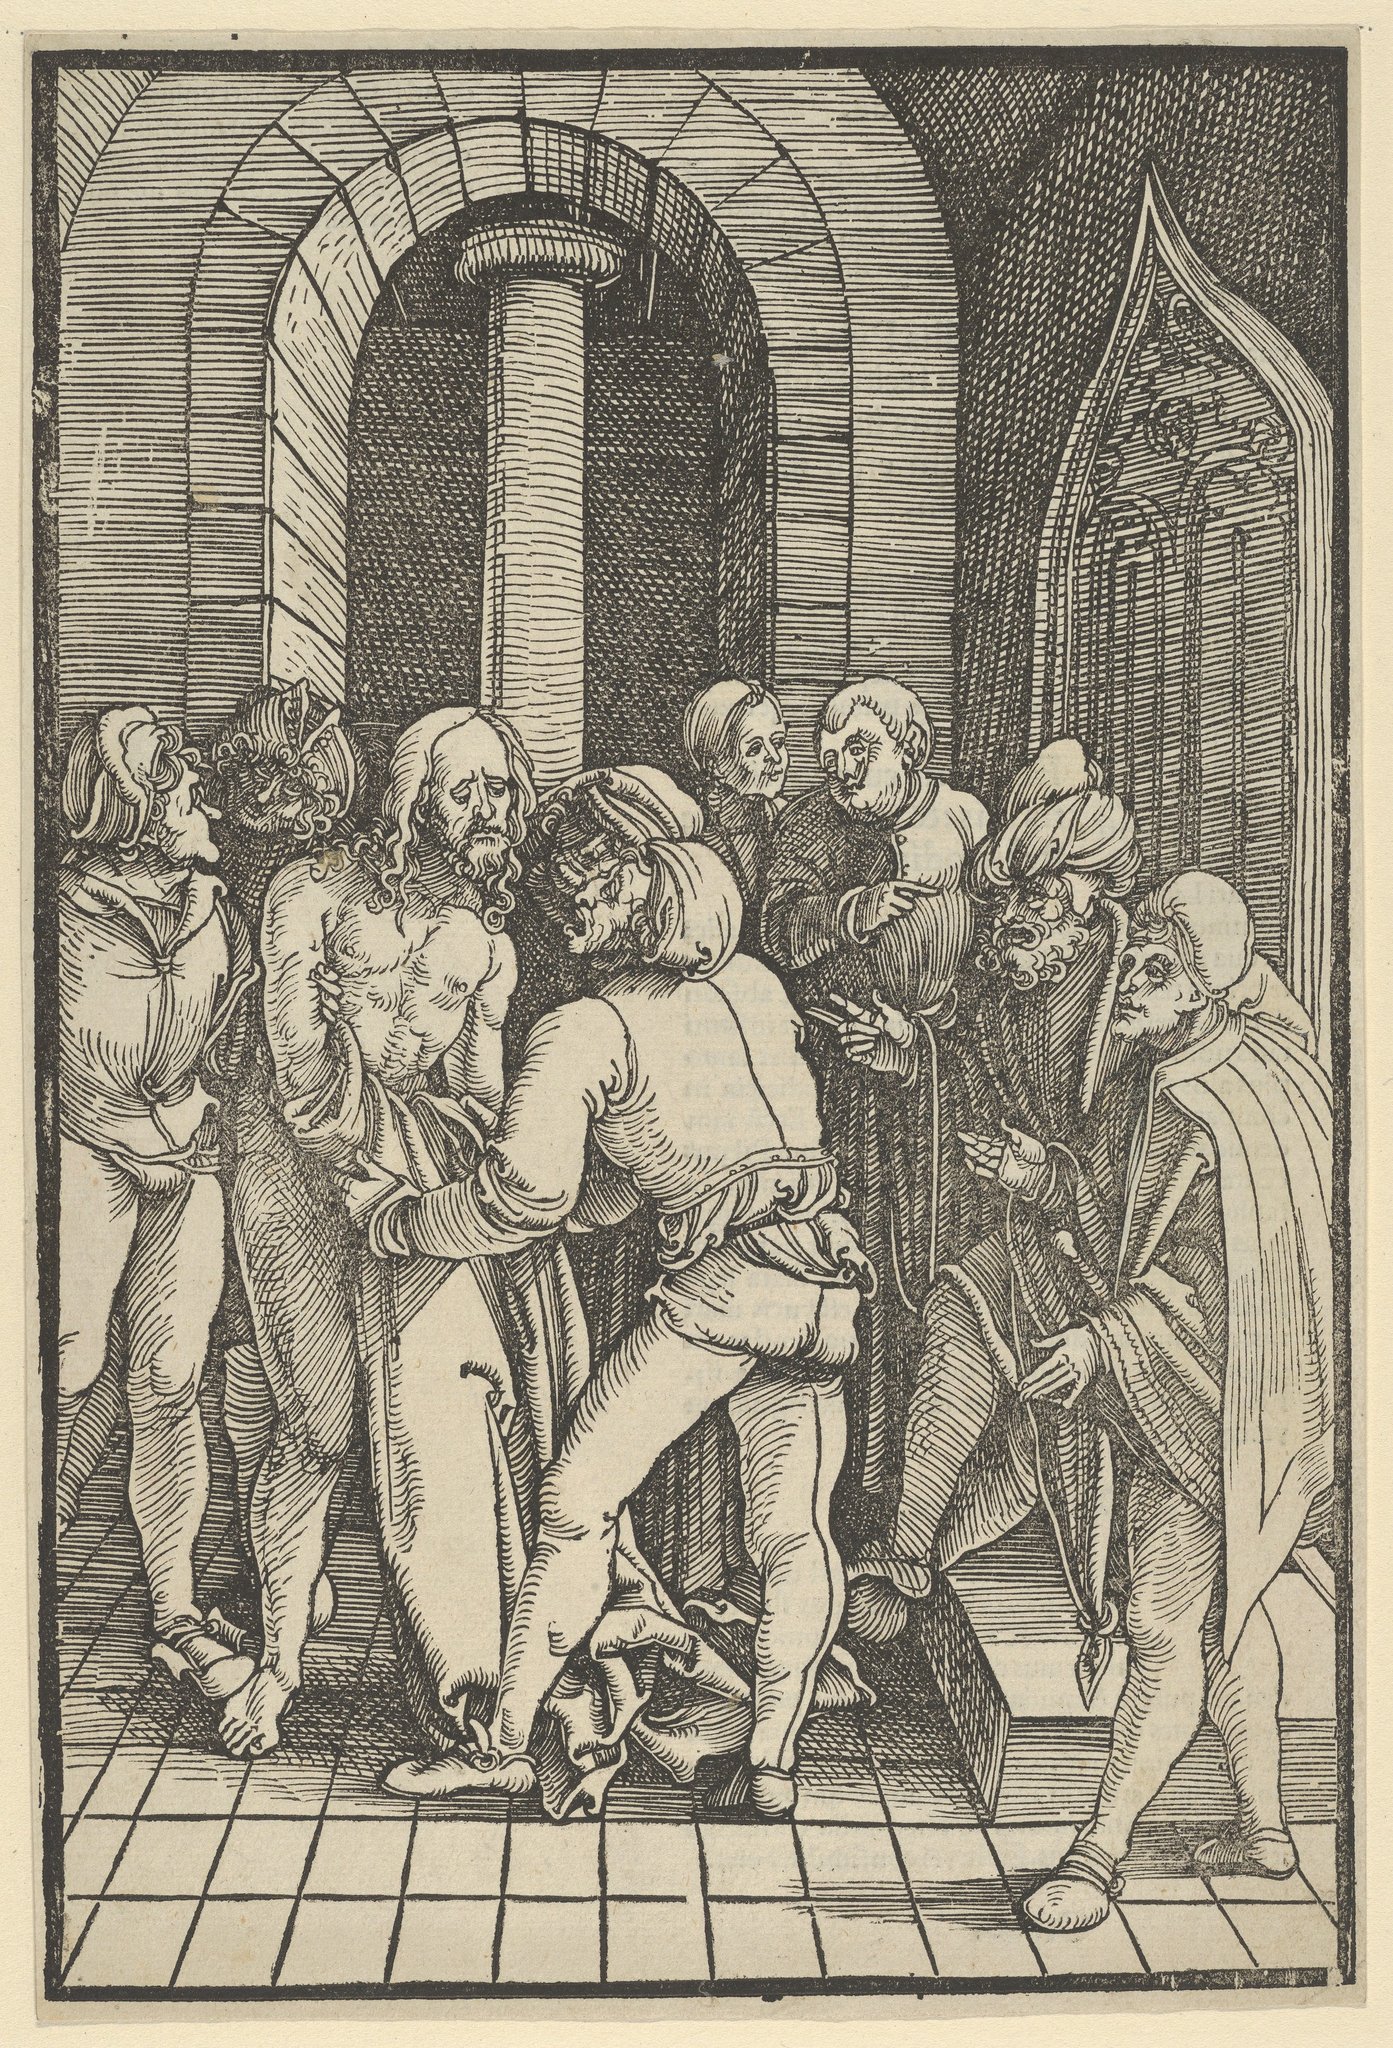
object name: print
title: Christ Stripped, from "Speculum passionis domini nostri Ihesu Christi"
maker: hans schäufelein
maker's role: artist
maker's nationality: german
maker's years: 1480-1540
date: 1507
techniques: woodcut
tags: men,women,christ